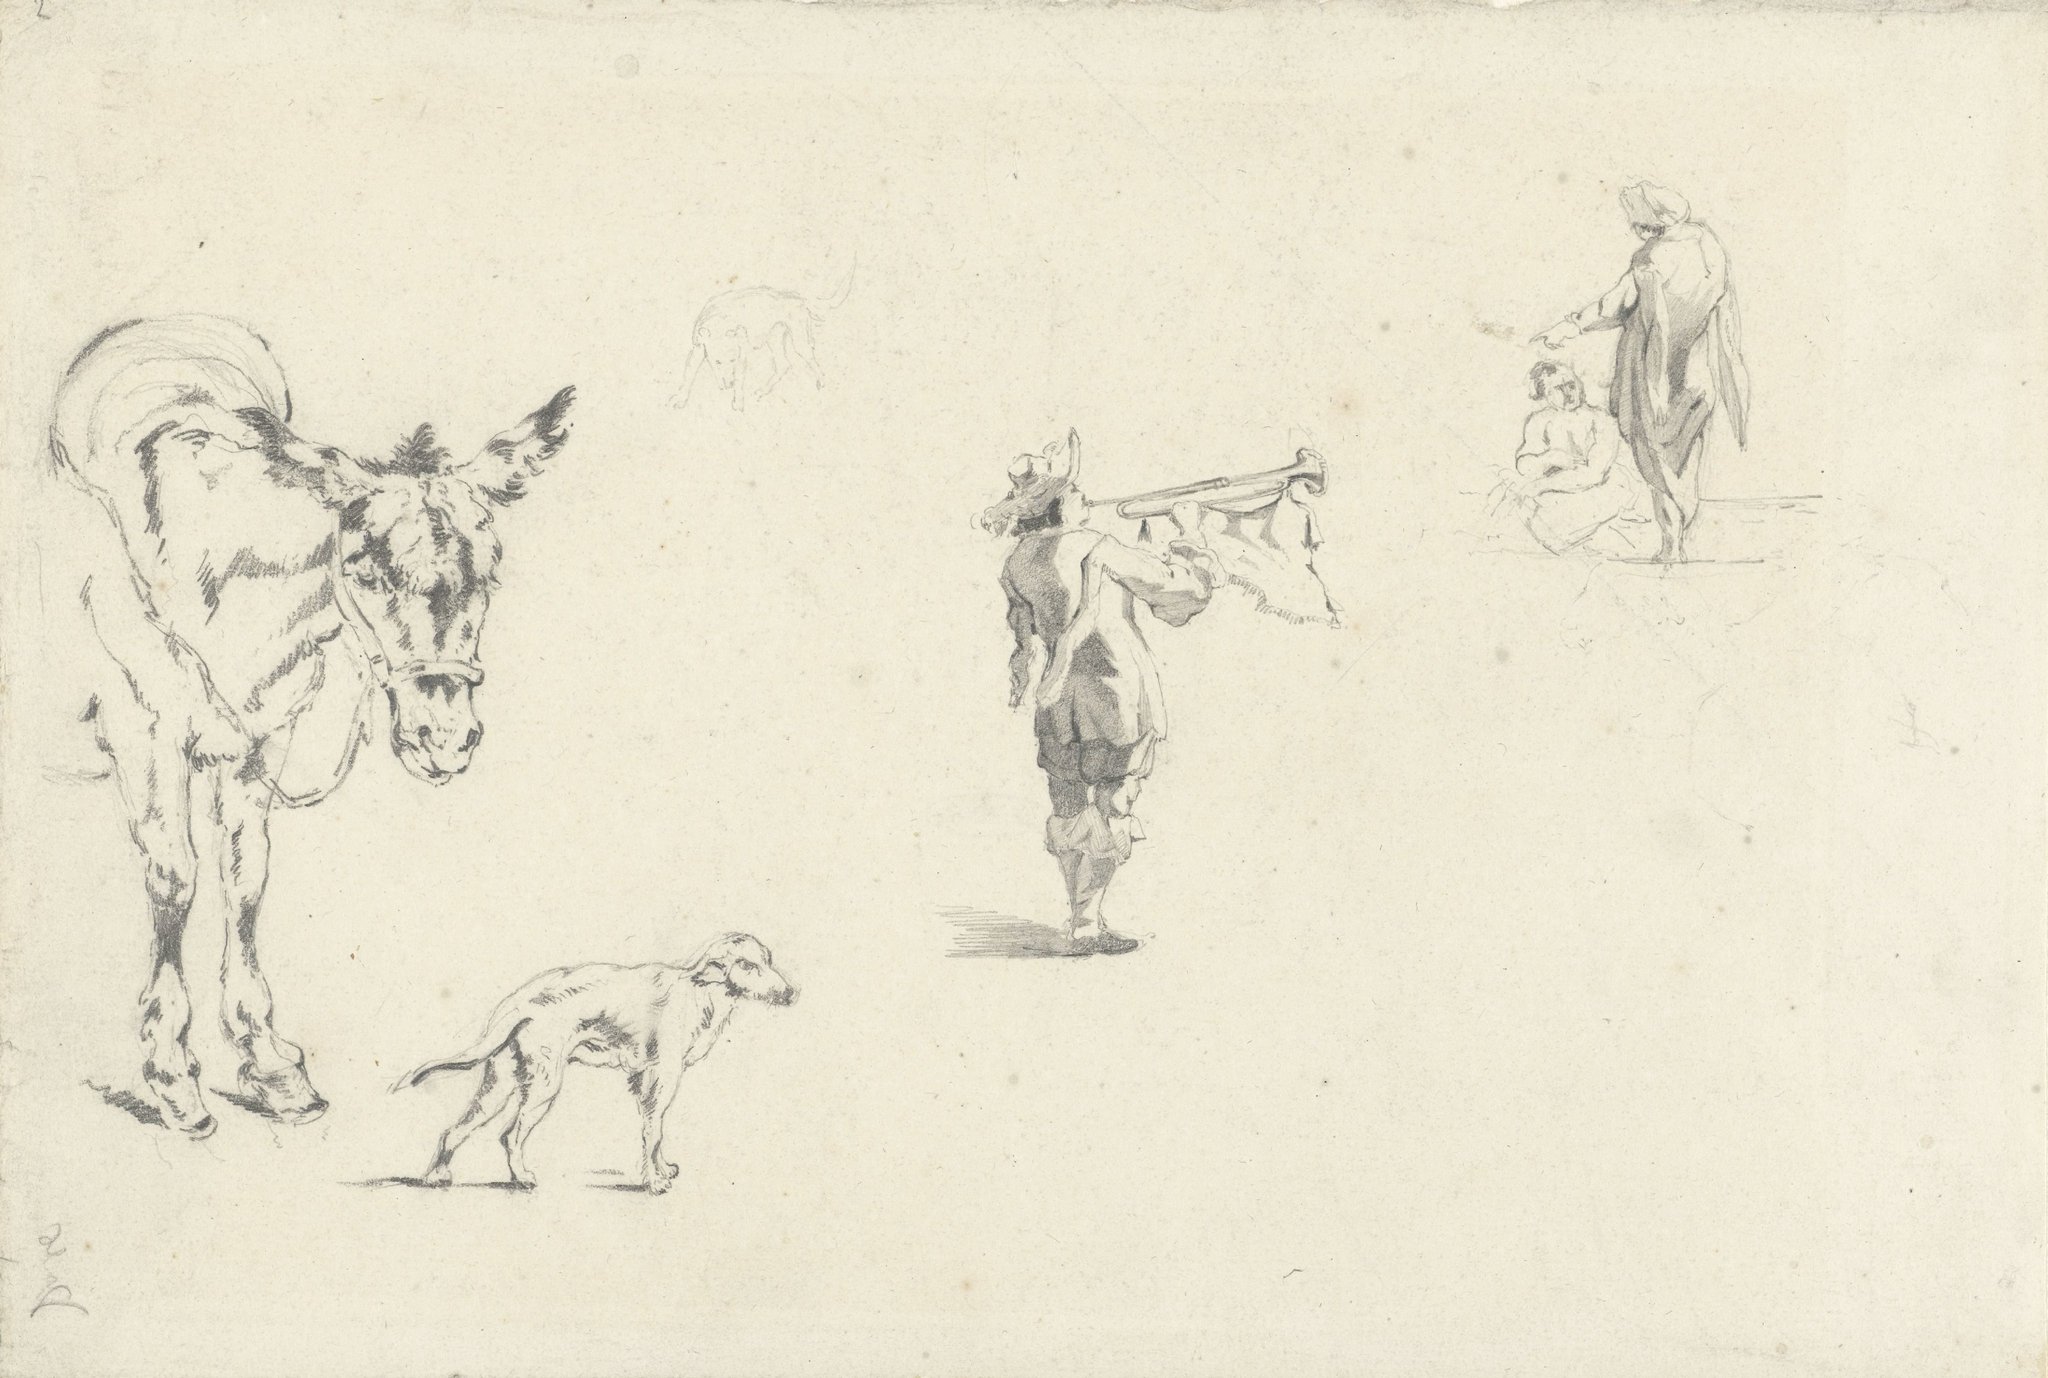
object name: drawing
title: Studies van onder andere een ezel, een hond en een trompetter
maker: gerard bilders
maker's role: draughtsman, print maker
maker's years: 1838-1865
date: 1848-1865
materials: paper, pencil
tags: ass, donkey, horn, trumpet, cornet, trombone, tuba, one person playing wind instrument, military music, dog